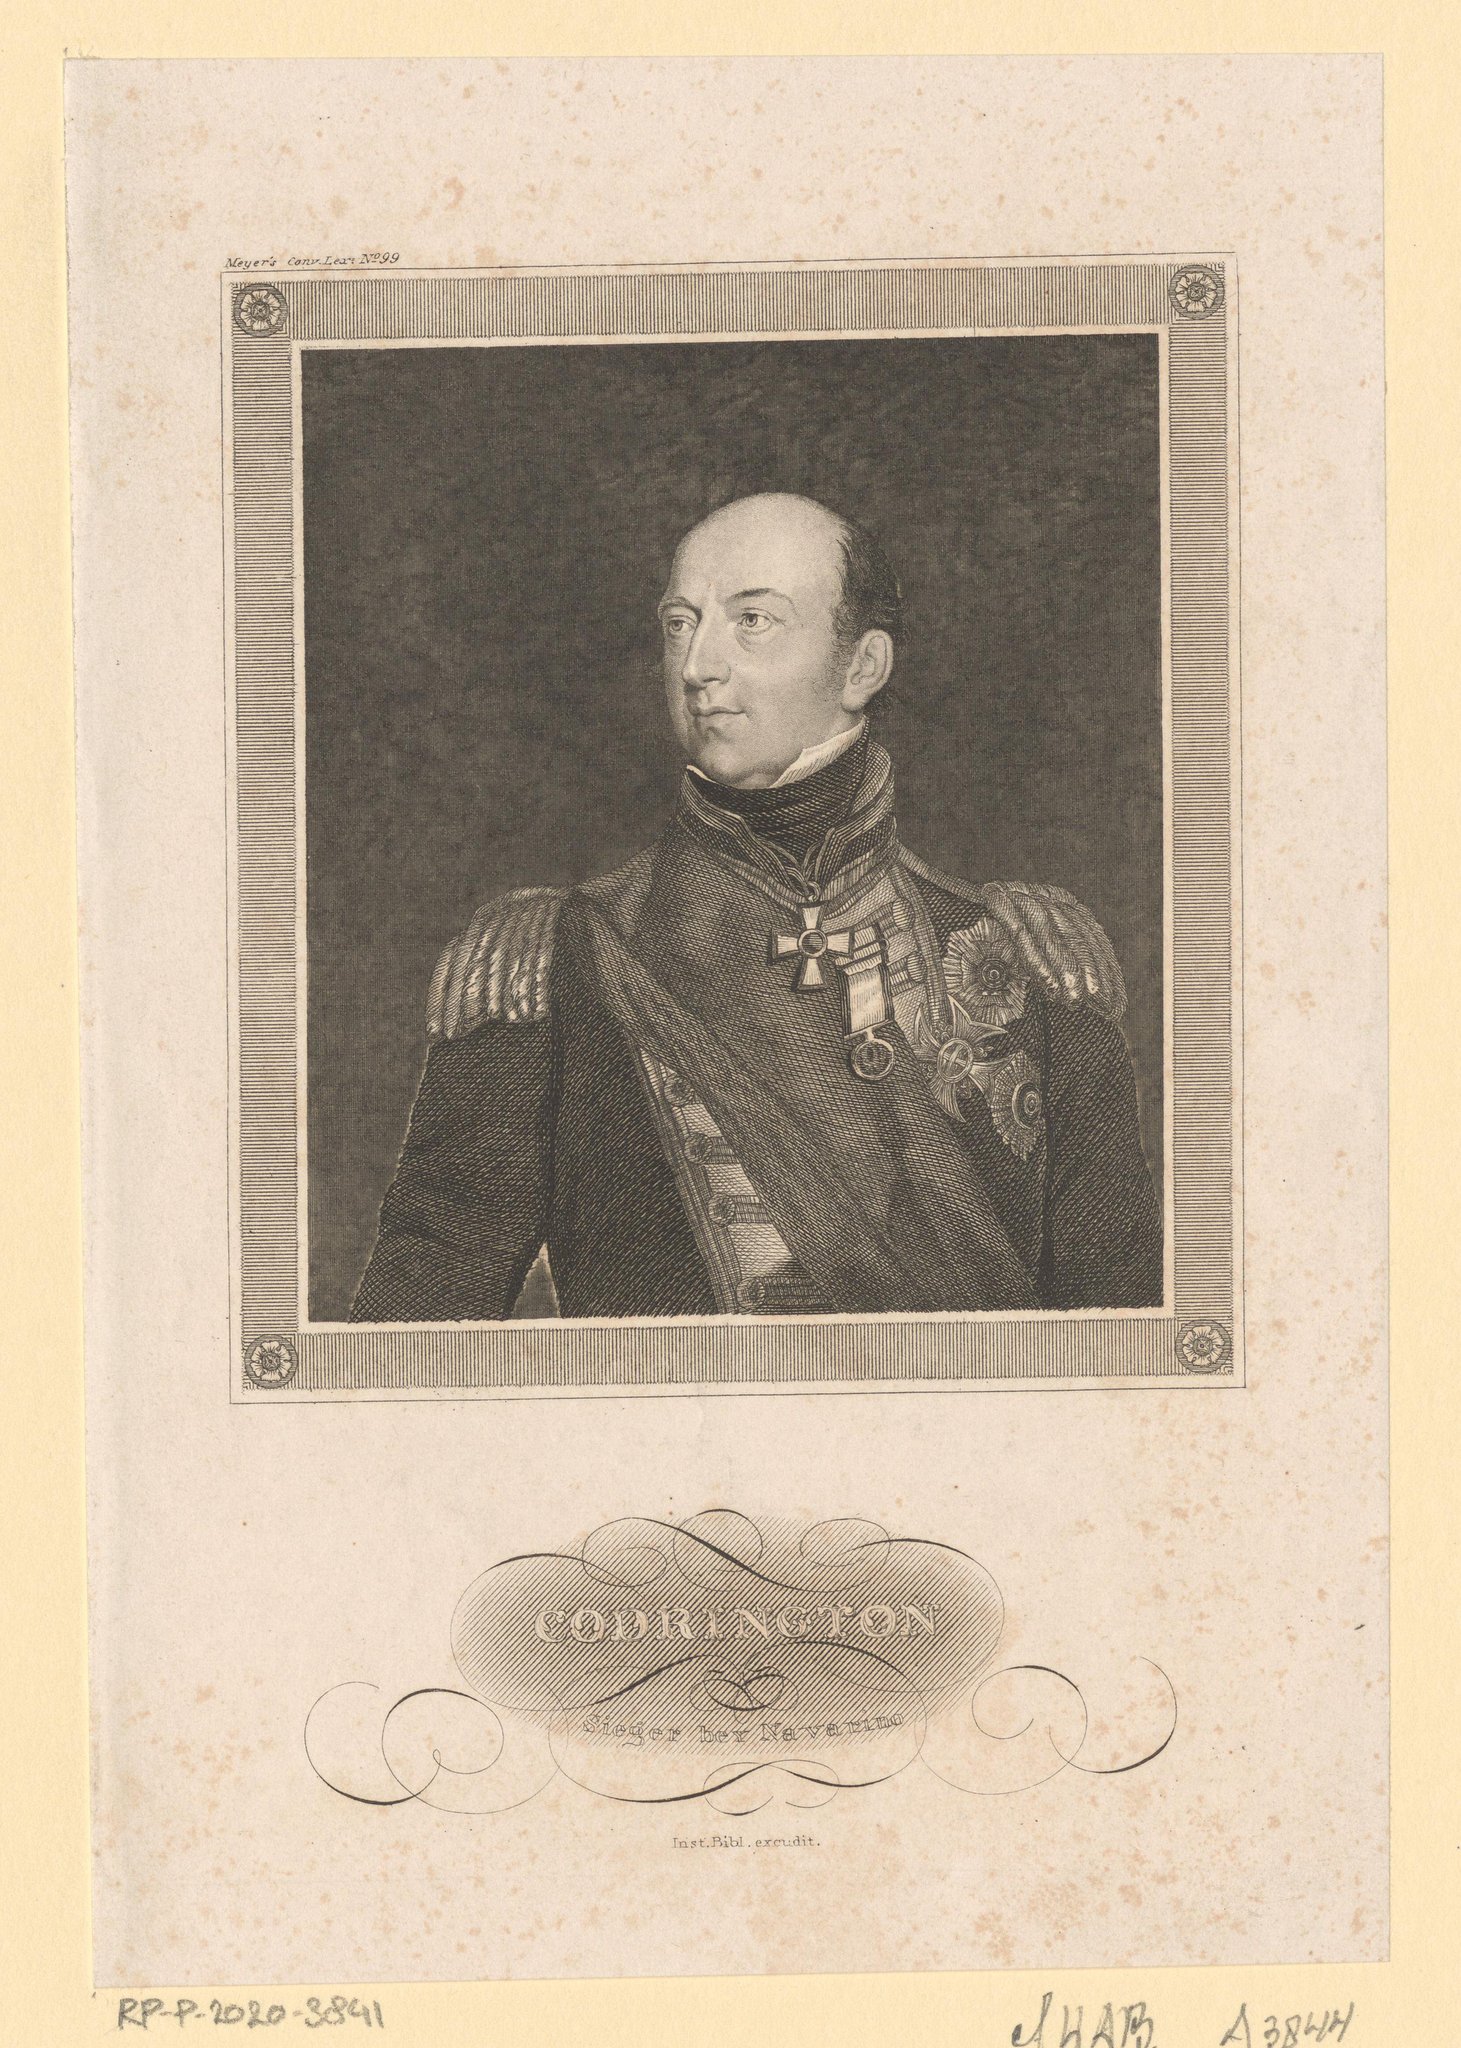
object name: print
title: Portret van Sir Edward Codrington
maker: Anonymous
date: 1839-1855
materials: paper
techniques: etching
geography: hildburghausen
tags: london, historical persons, battle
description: Prent mogelijk uit: Meyer, Joseph. Conversations-Lexikon für die gebildeten Stände. Hildburghausen: Bibliographisches Institut, 1839-1855.